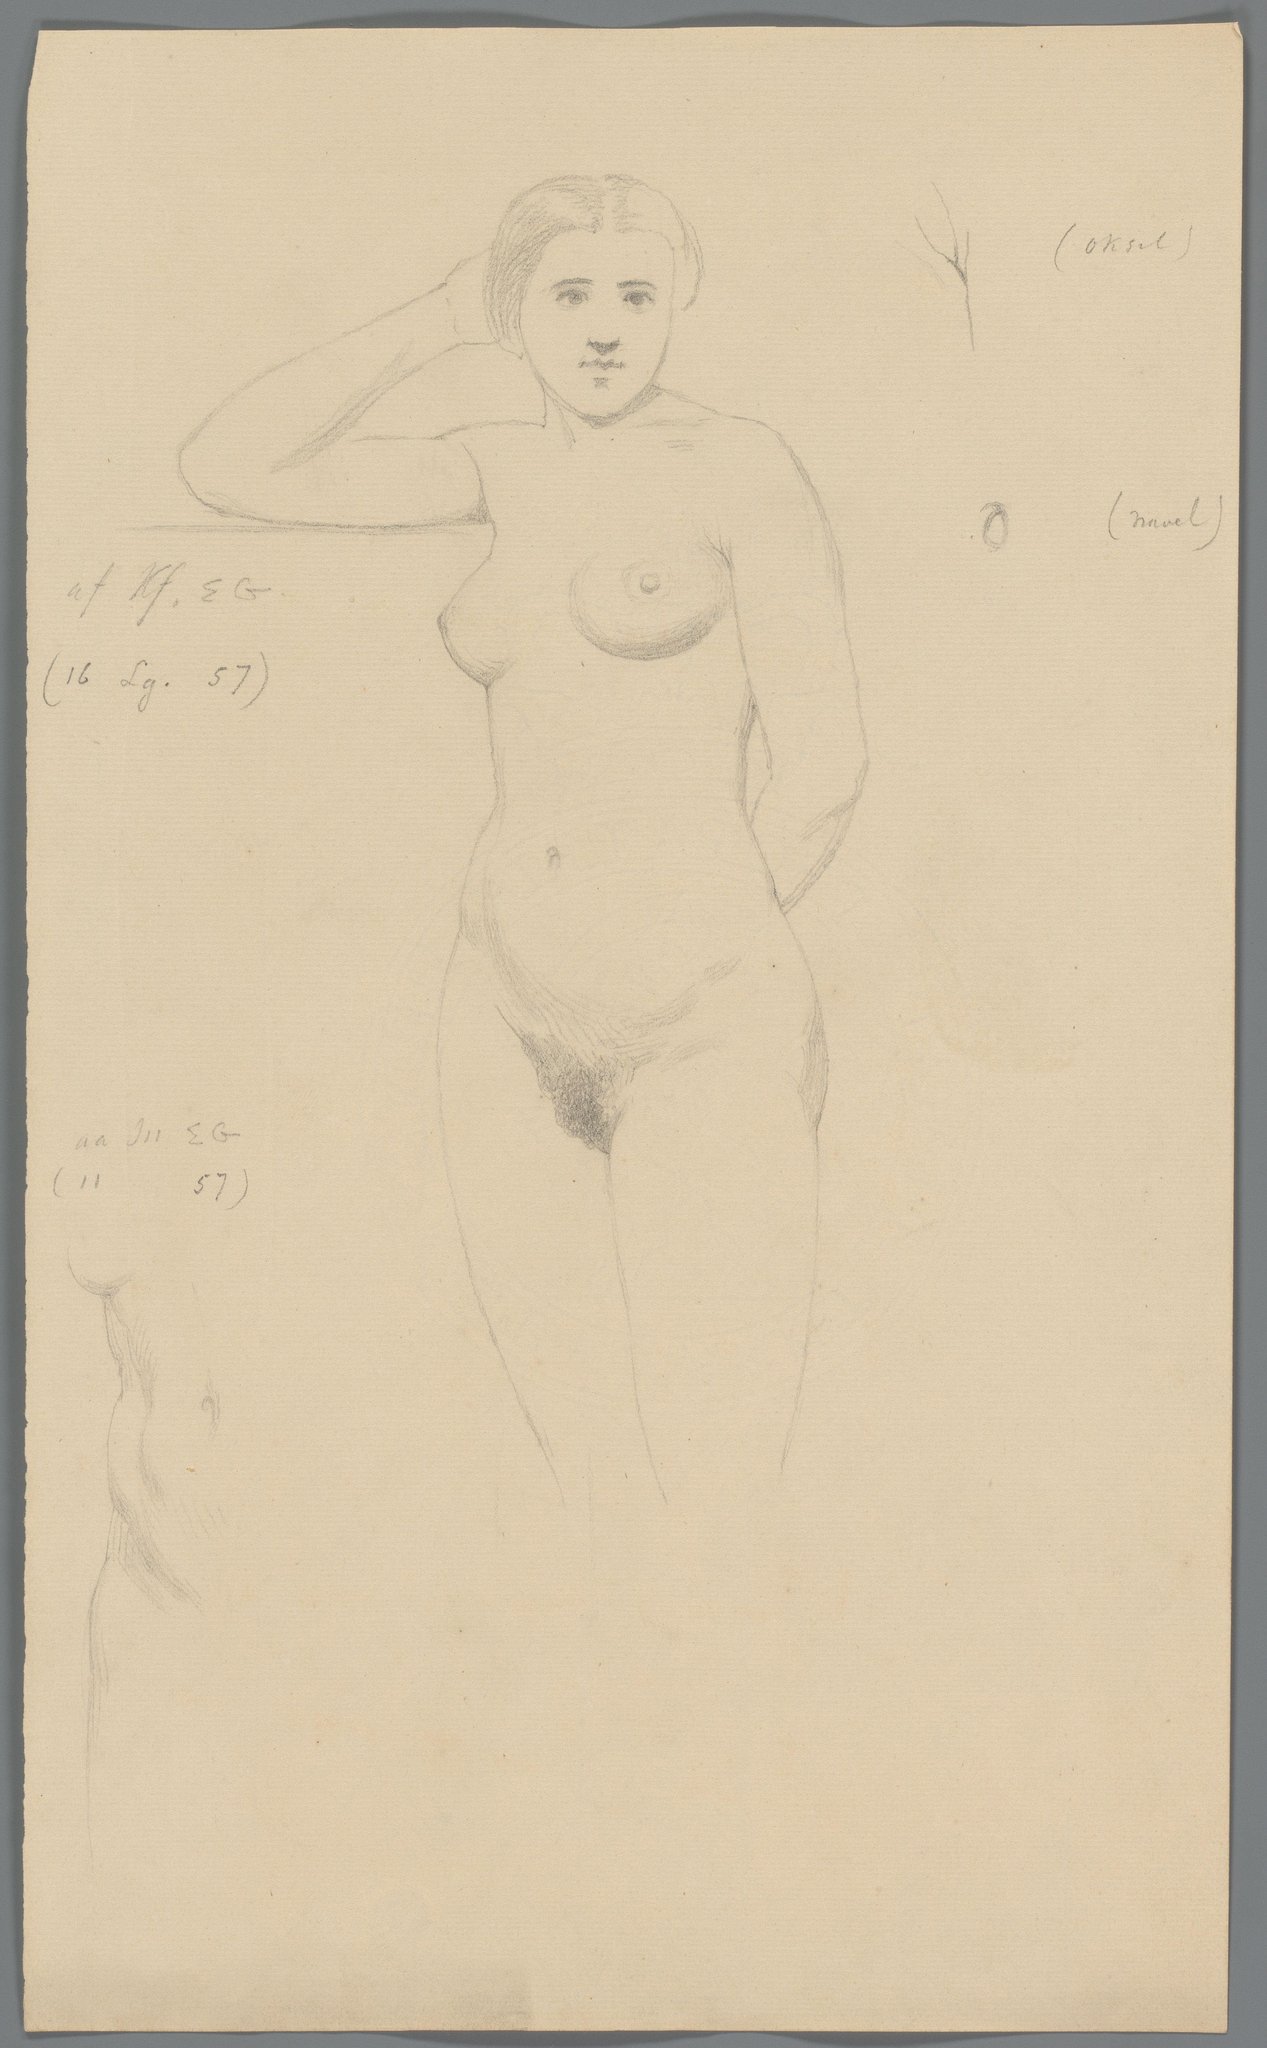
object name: drawing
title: Studie van een vrouw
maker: jacobus everhardus josephus van den berg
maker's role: draughtsman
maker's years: 1802-1861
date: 1857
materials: paper, pencil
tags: the (nude) human figure; 'corpo humano' (ripa) - aa - female human figure